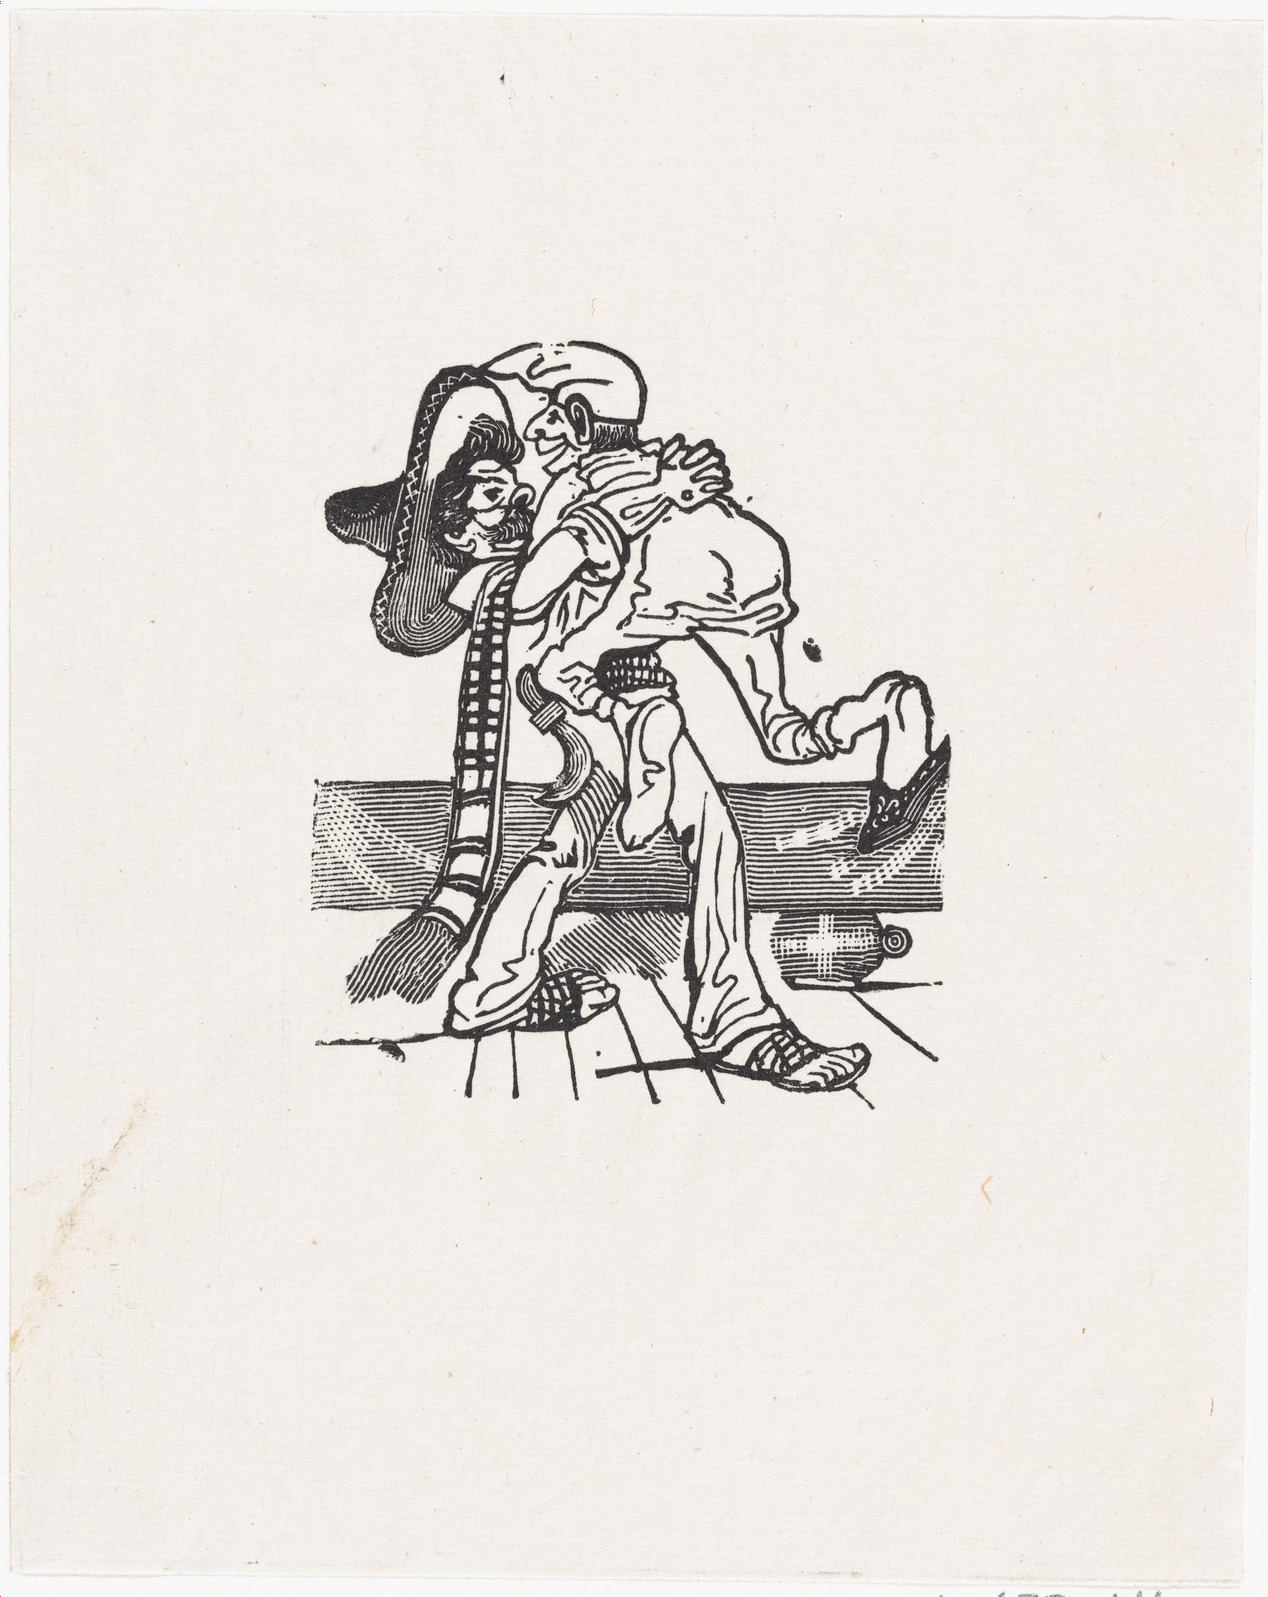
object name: print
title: One man lifting another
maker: josé guadalupe posada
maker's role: artist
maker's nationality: mexican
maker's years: 1852-1913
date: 1880-1910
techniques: lithography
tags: men